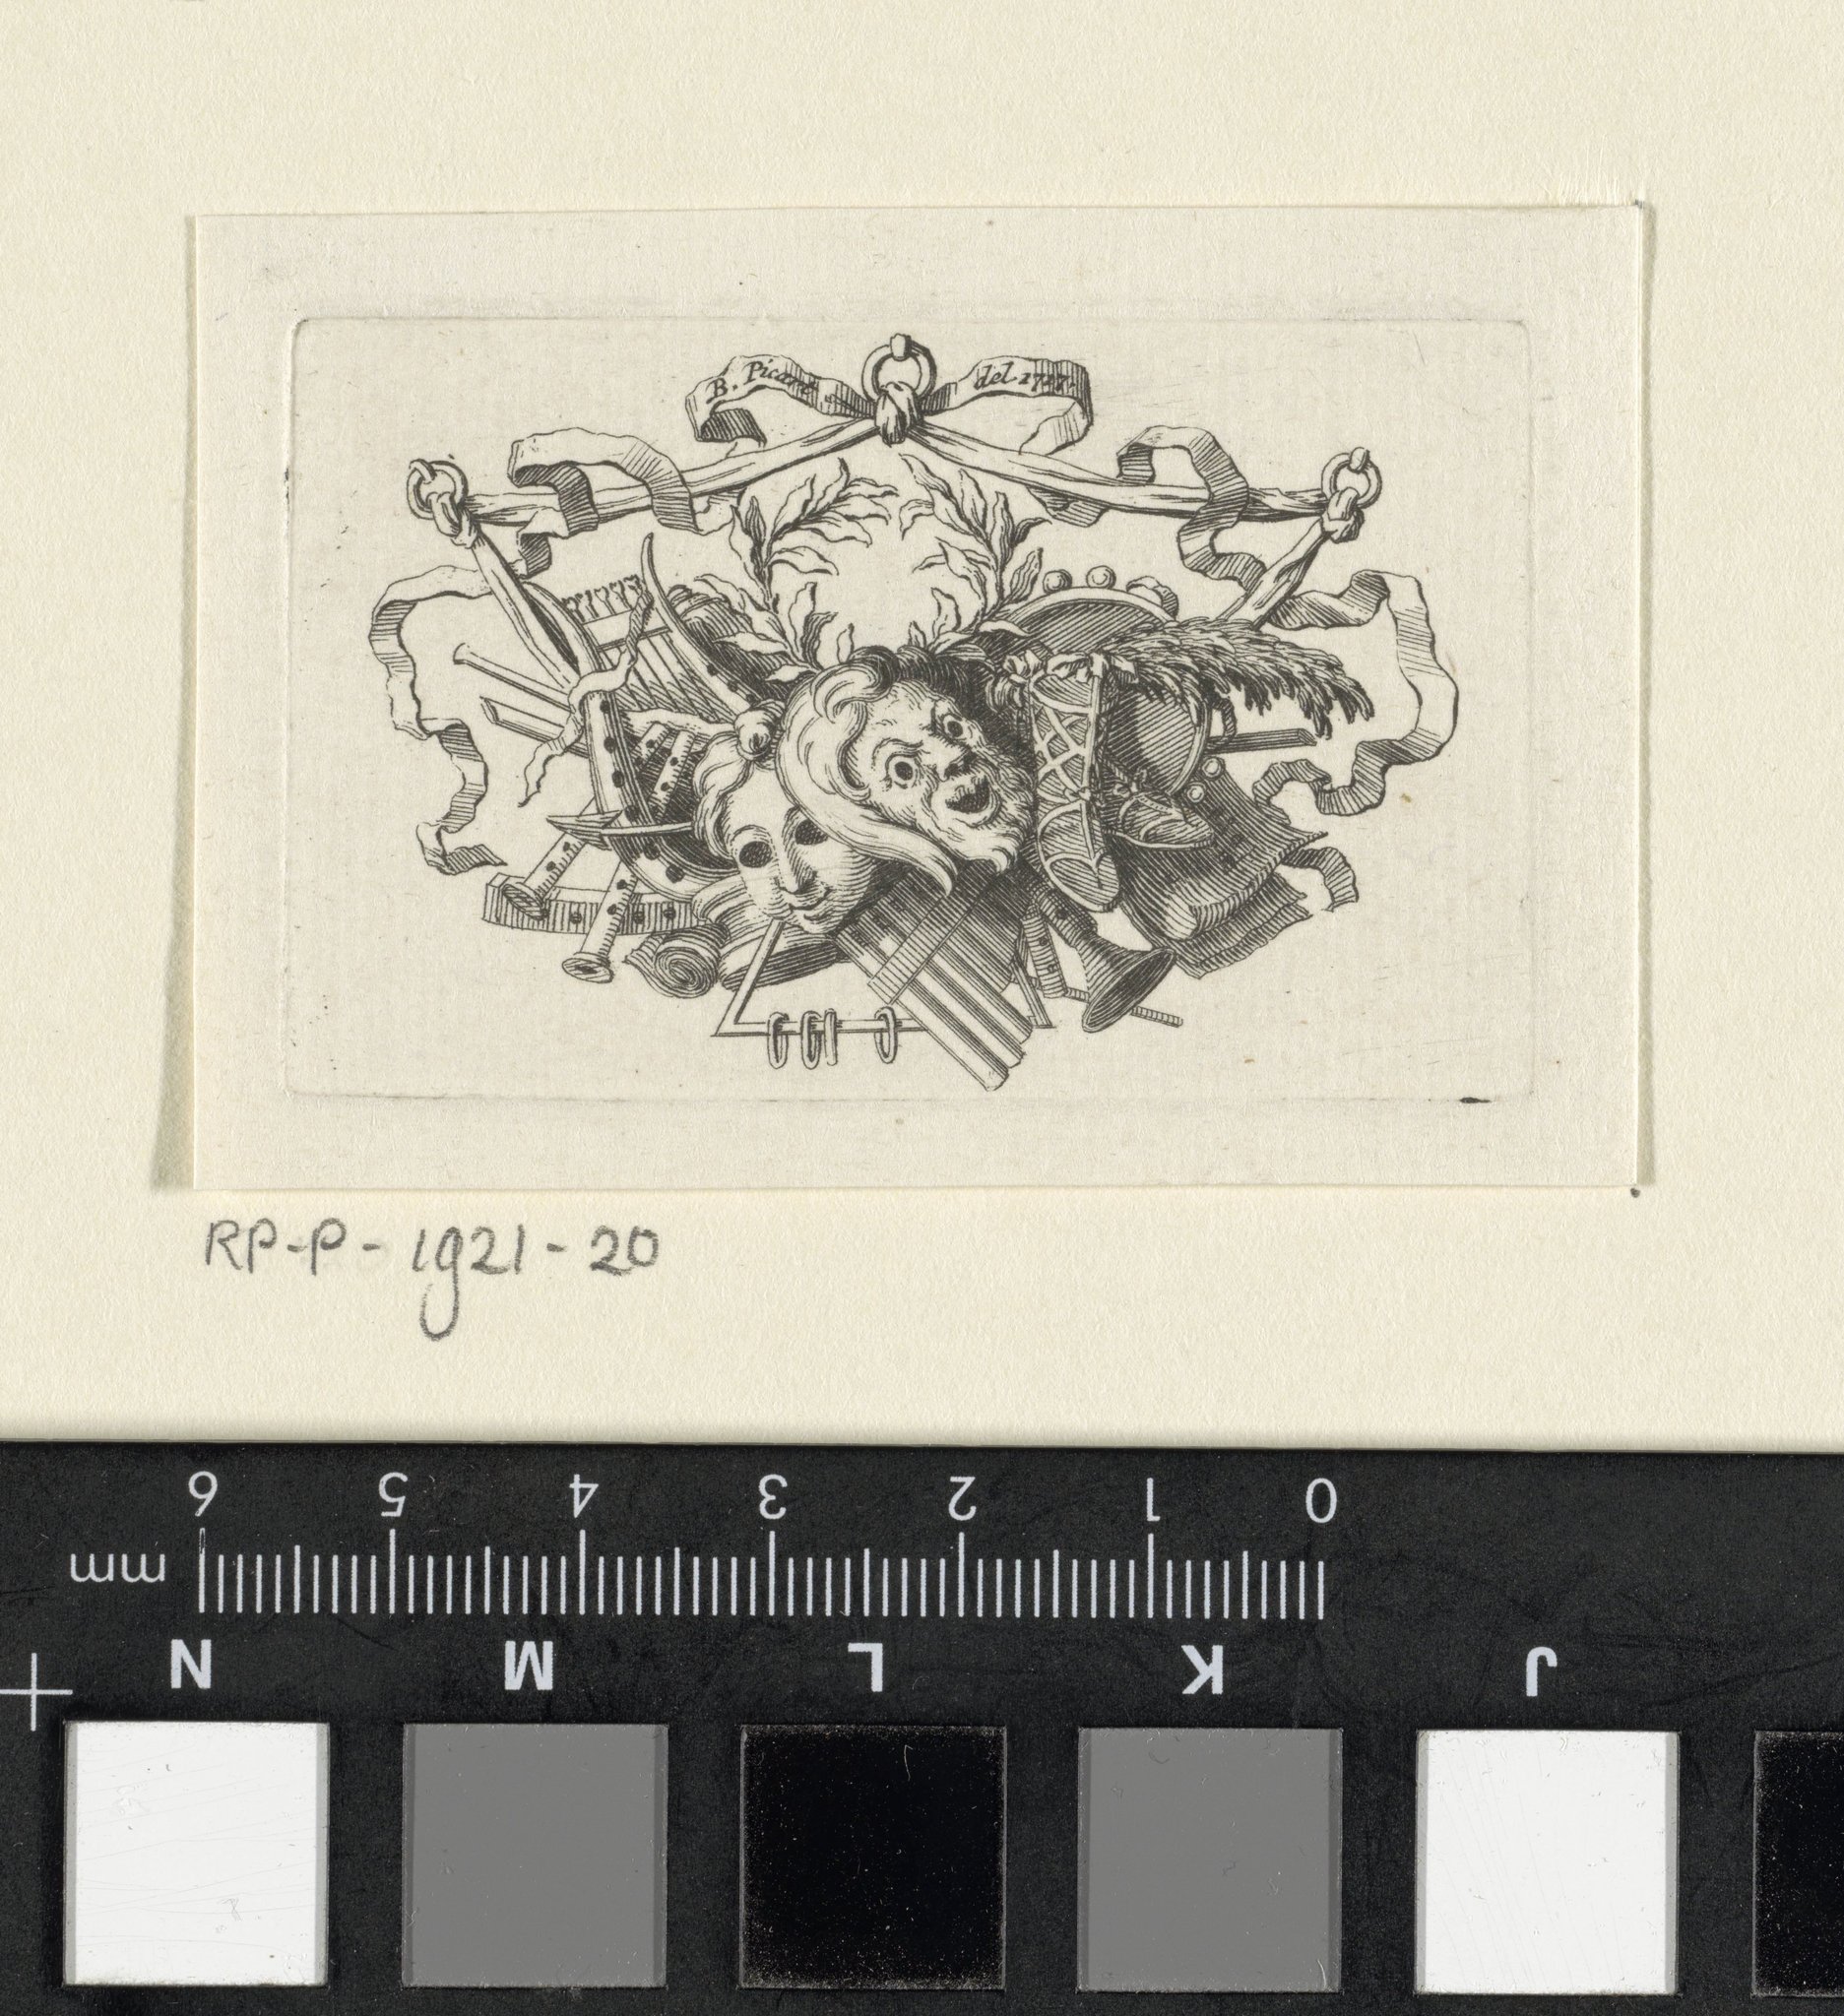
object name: ornament print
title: Vignet met maskers en muziekinstrumenten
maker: bernard picart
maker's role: draughtsman, print maker, publisher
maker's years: 1673-1733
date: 1717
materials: paper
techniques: engraving, etching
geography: amsterdam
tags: mask, musical instruments; group of musical instruments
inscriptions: collector's mark: Lugt 2233